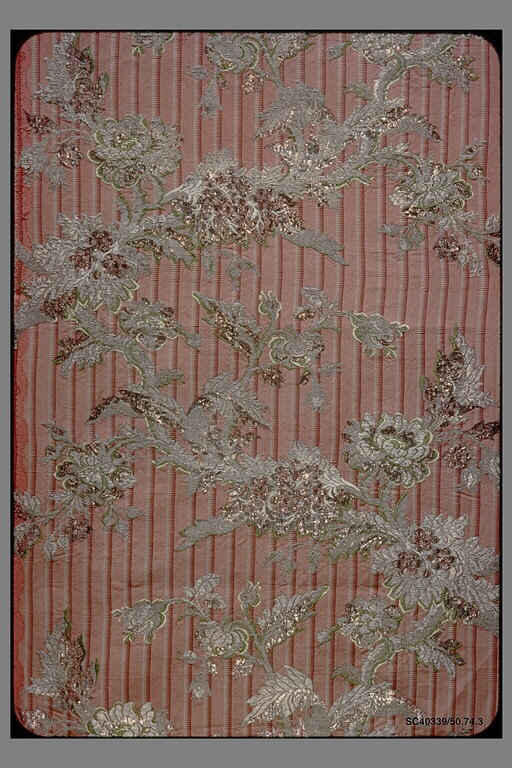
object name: piece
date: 1750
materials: metal thread, silk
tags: flowers,leaves